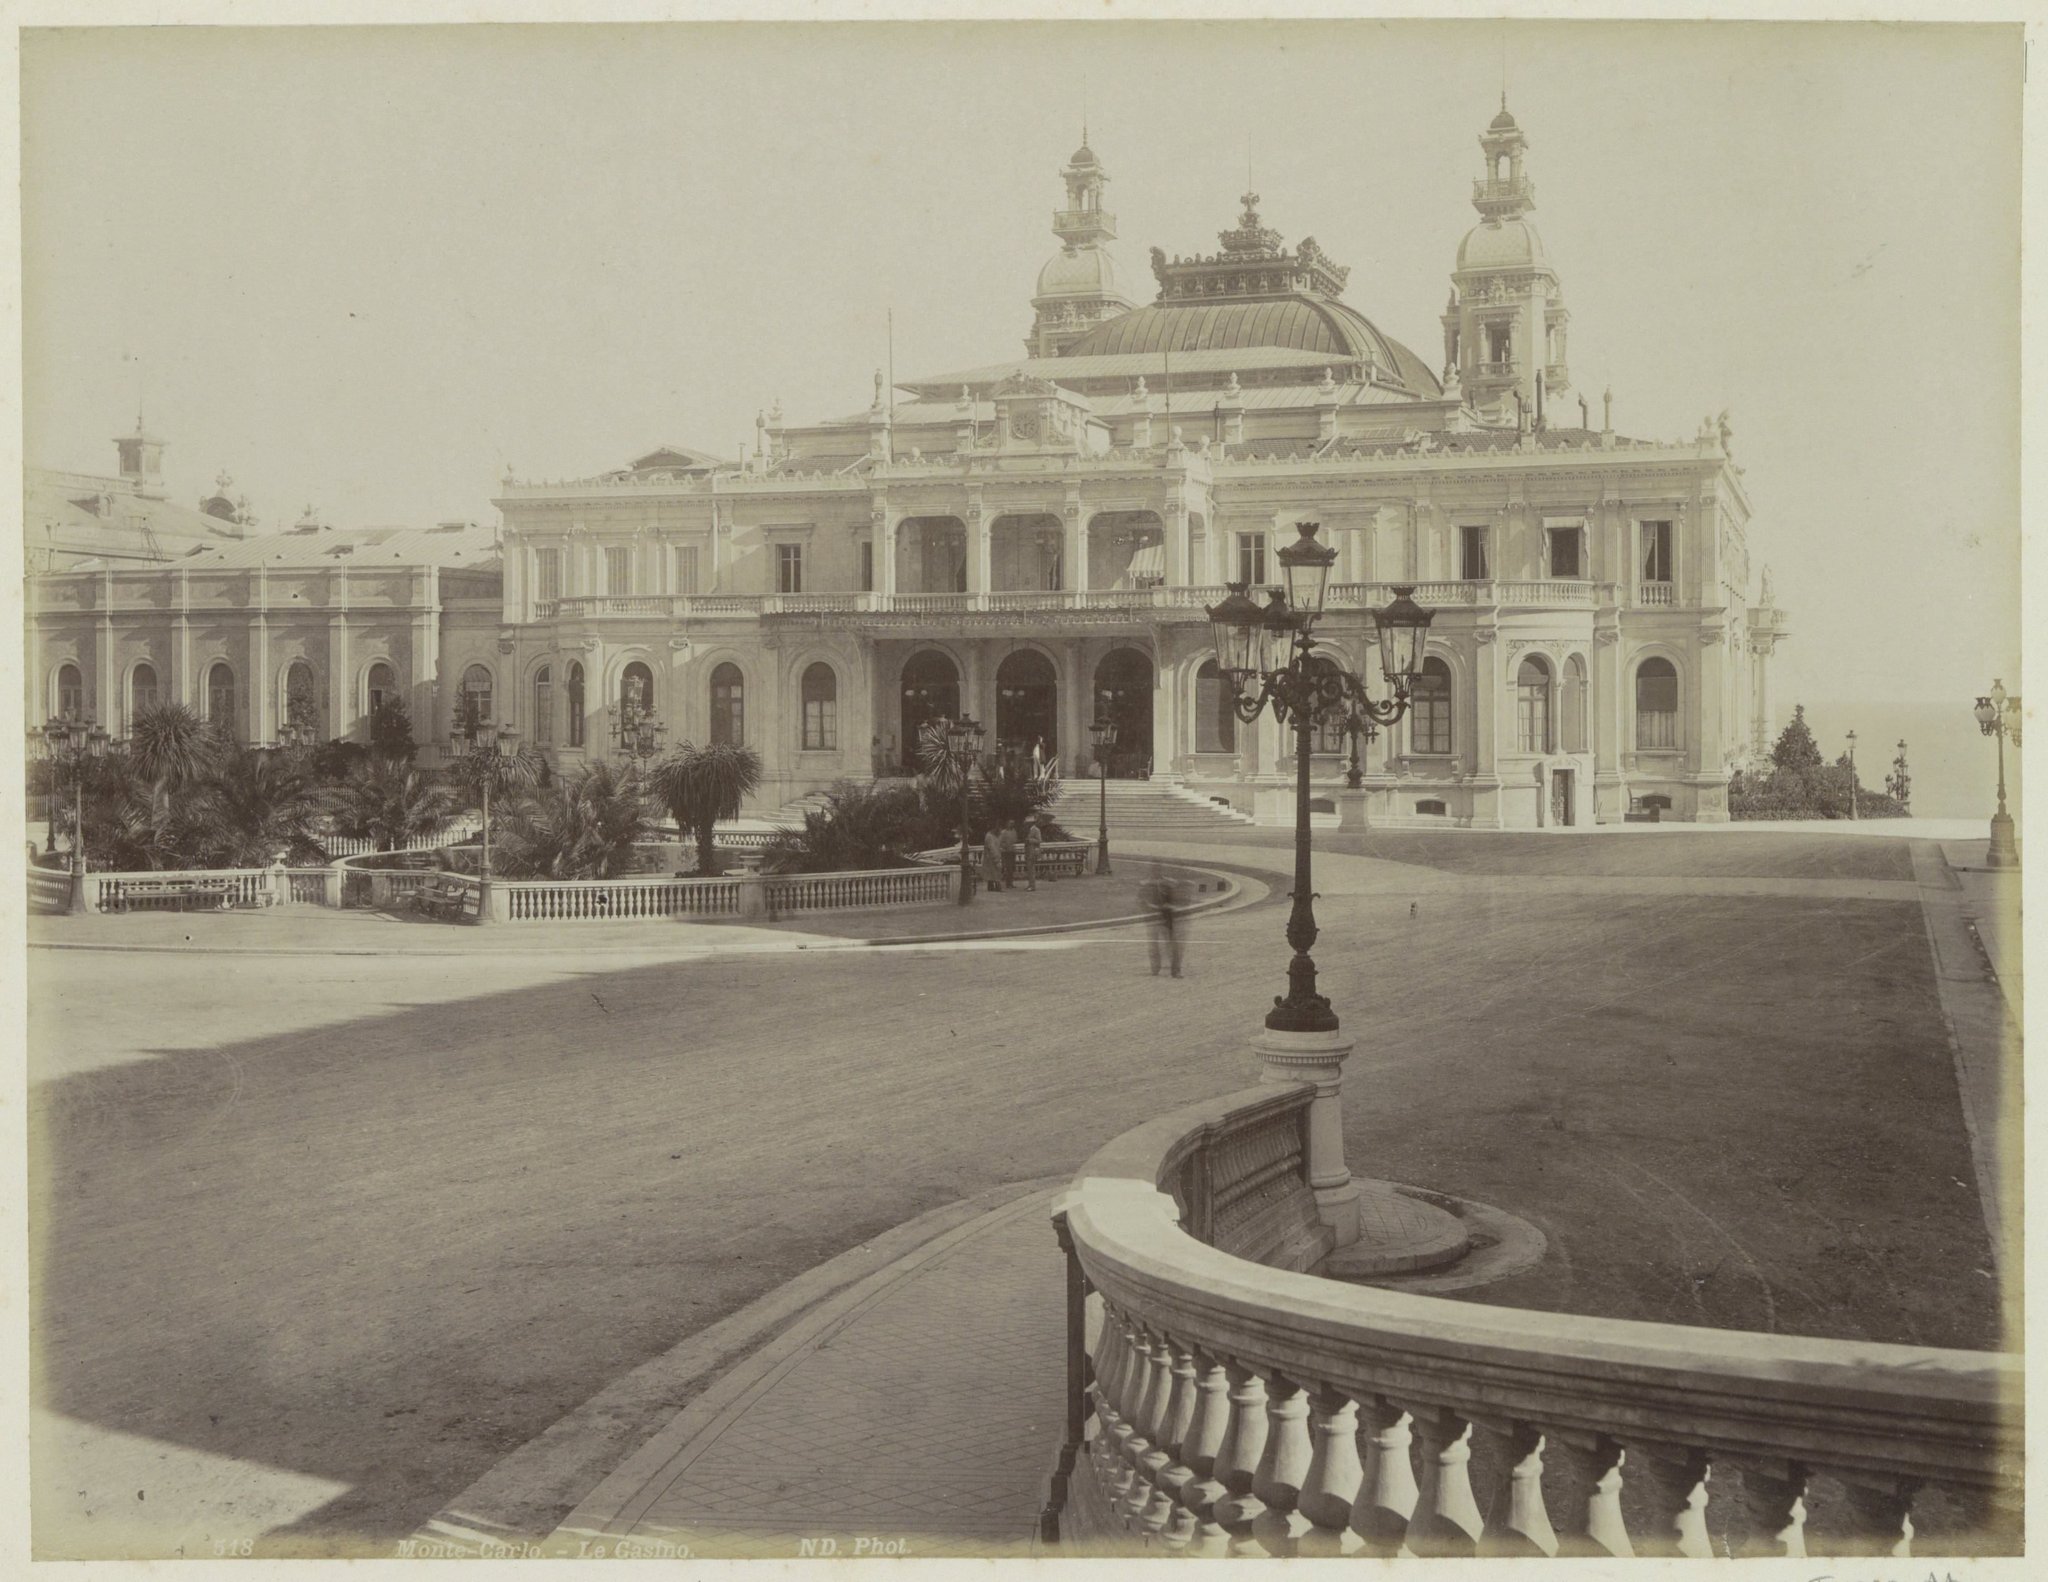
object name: photograph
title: Exterieur van het Monte Carlo Casino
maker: étienne neurdein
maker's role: publisher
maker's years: 1832-1918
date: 1870-1900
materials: paper, photographic support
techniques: albumen print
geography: monaco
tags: casino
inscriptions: negative number: ‘518’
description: Onderdeel van Reisalbum met foto's van bezienswaardigheden in Italië en Frankrijk.